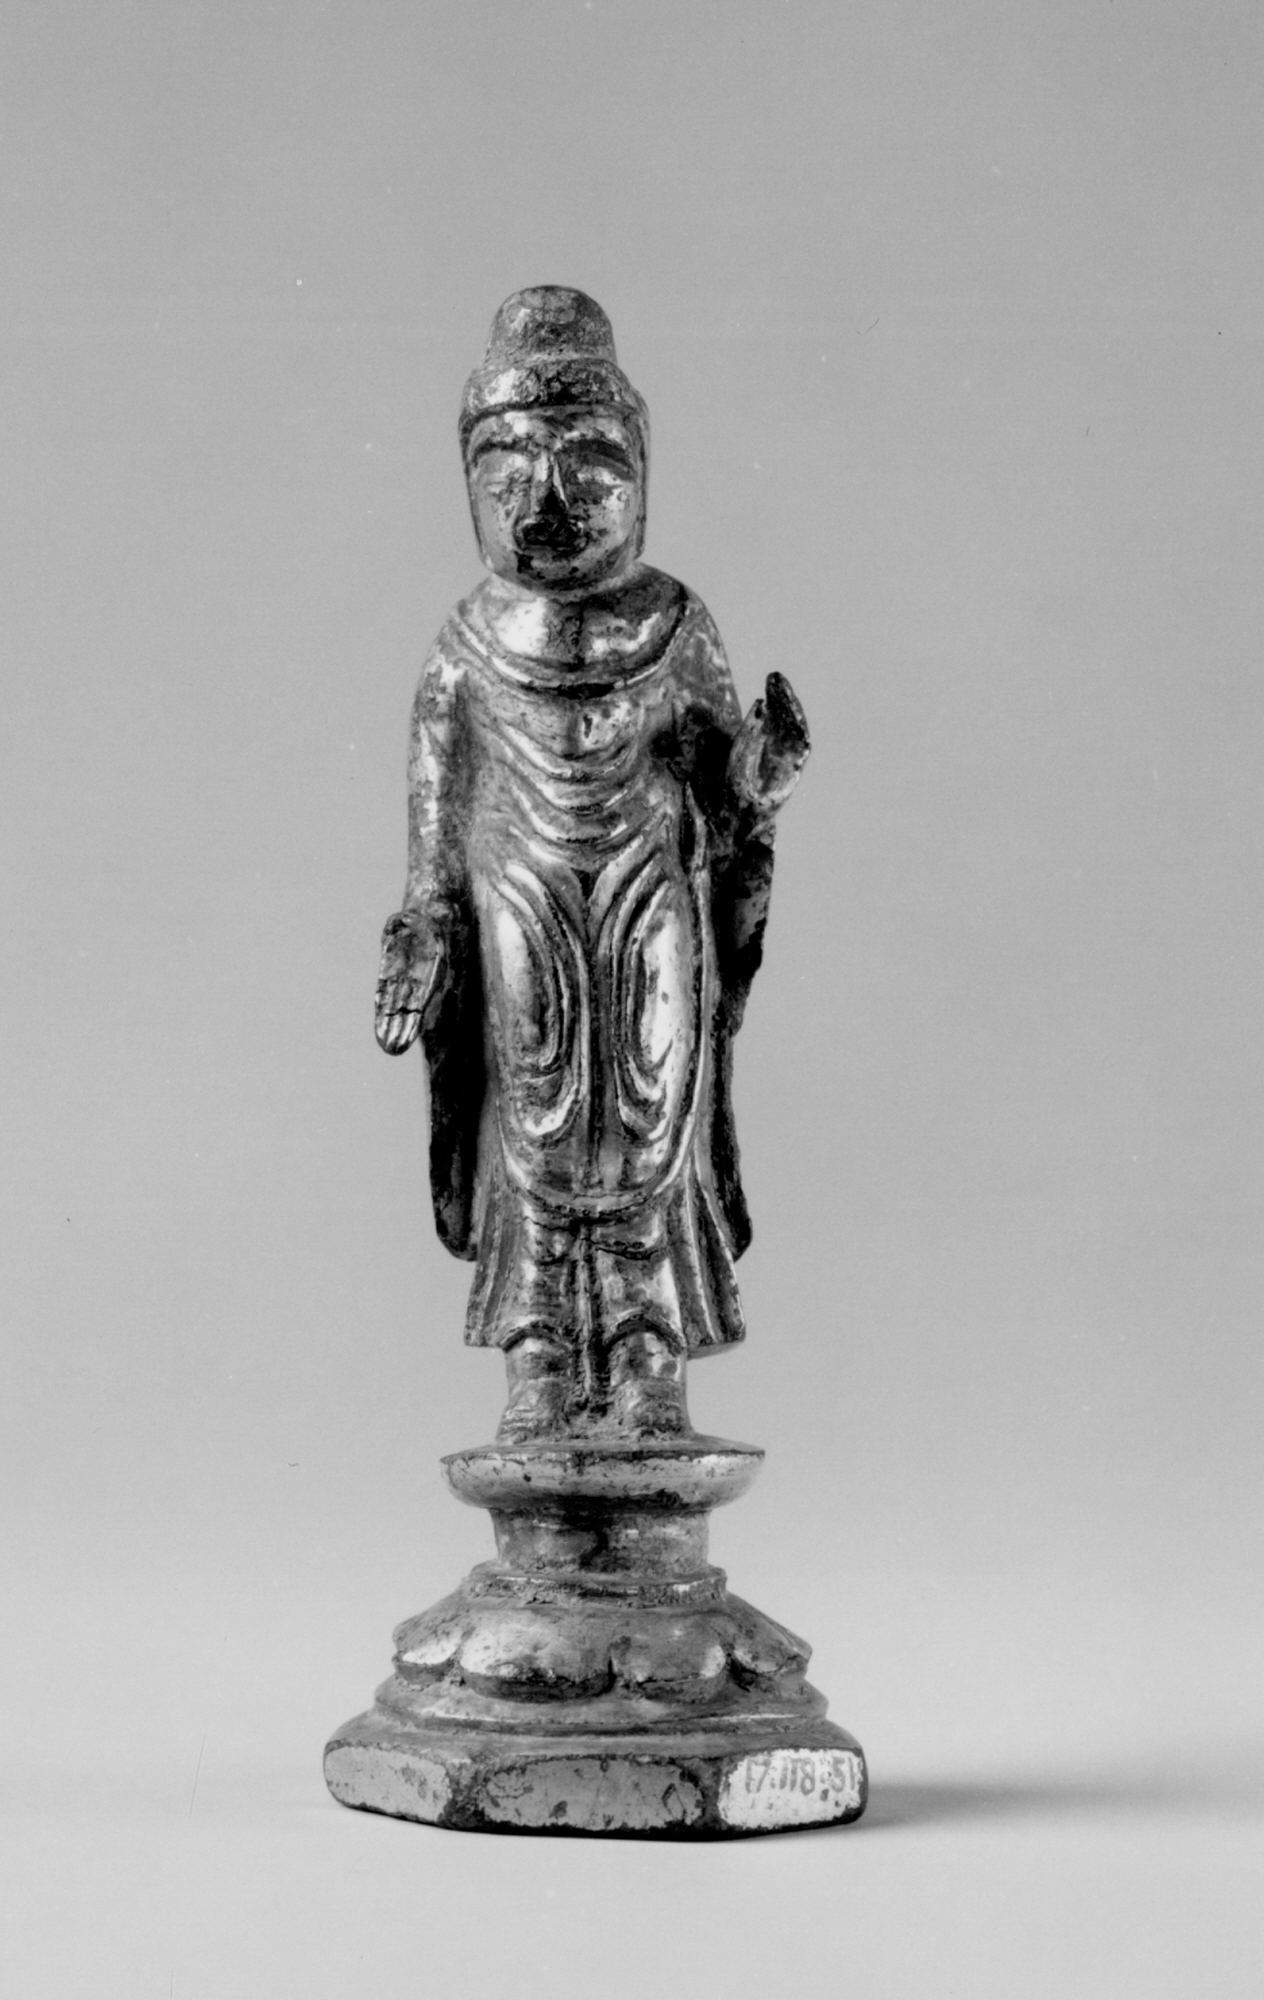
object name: statuette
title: Buddha on Stand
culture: korean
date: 601-700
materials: gilt bronze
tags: buddhism,buddha